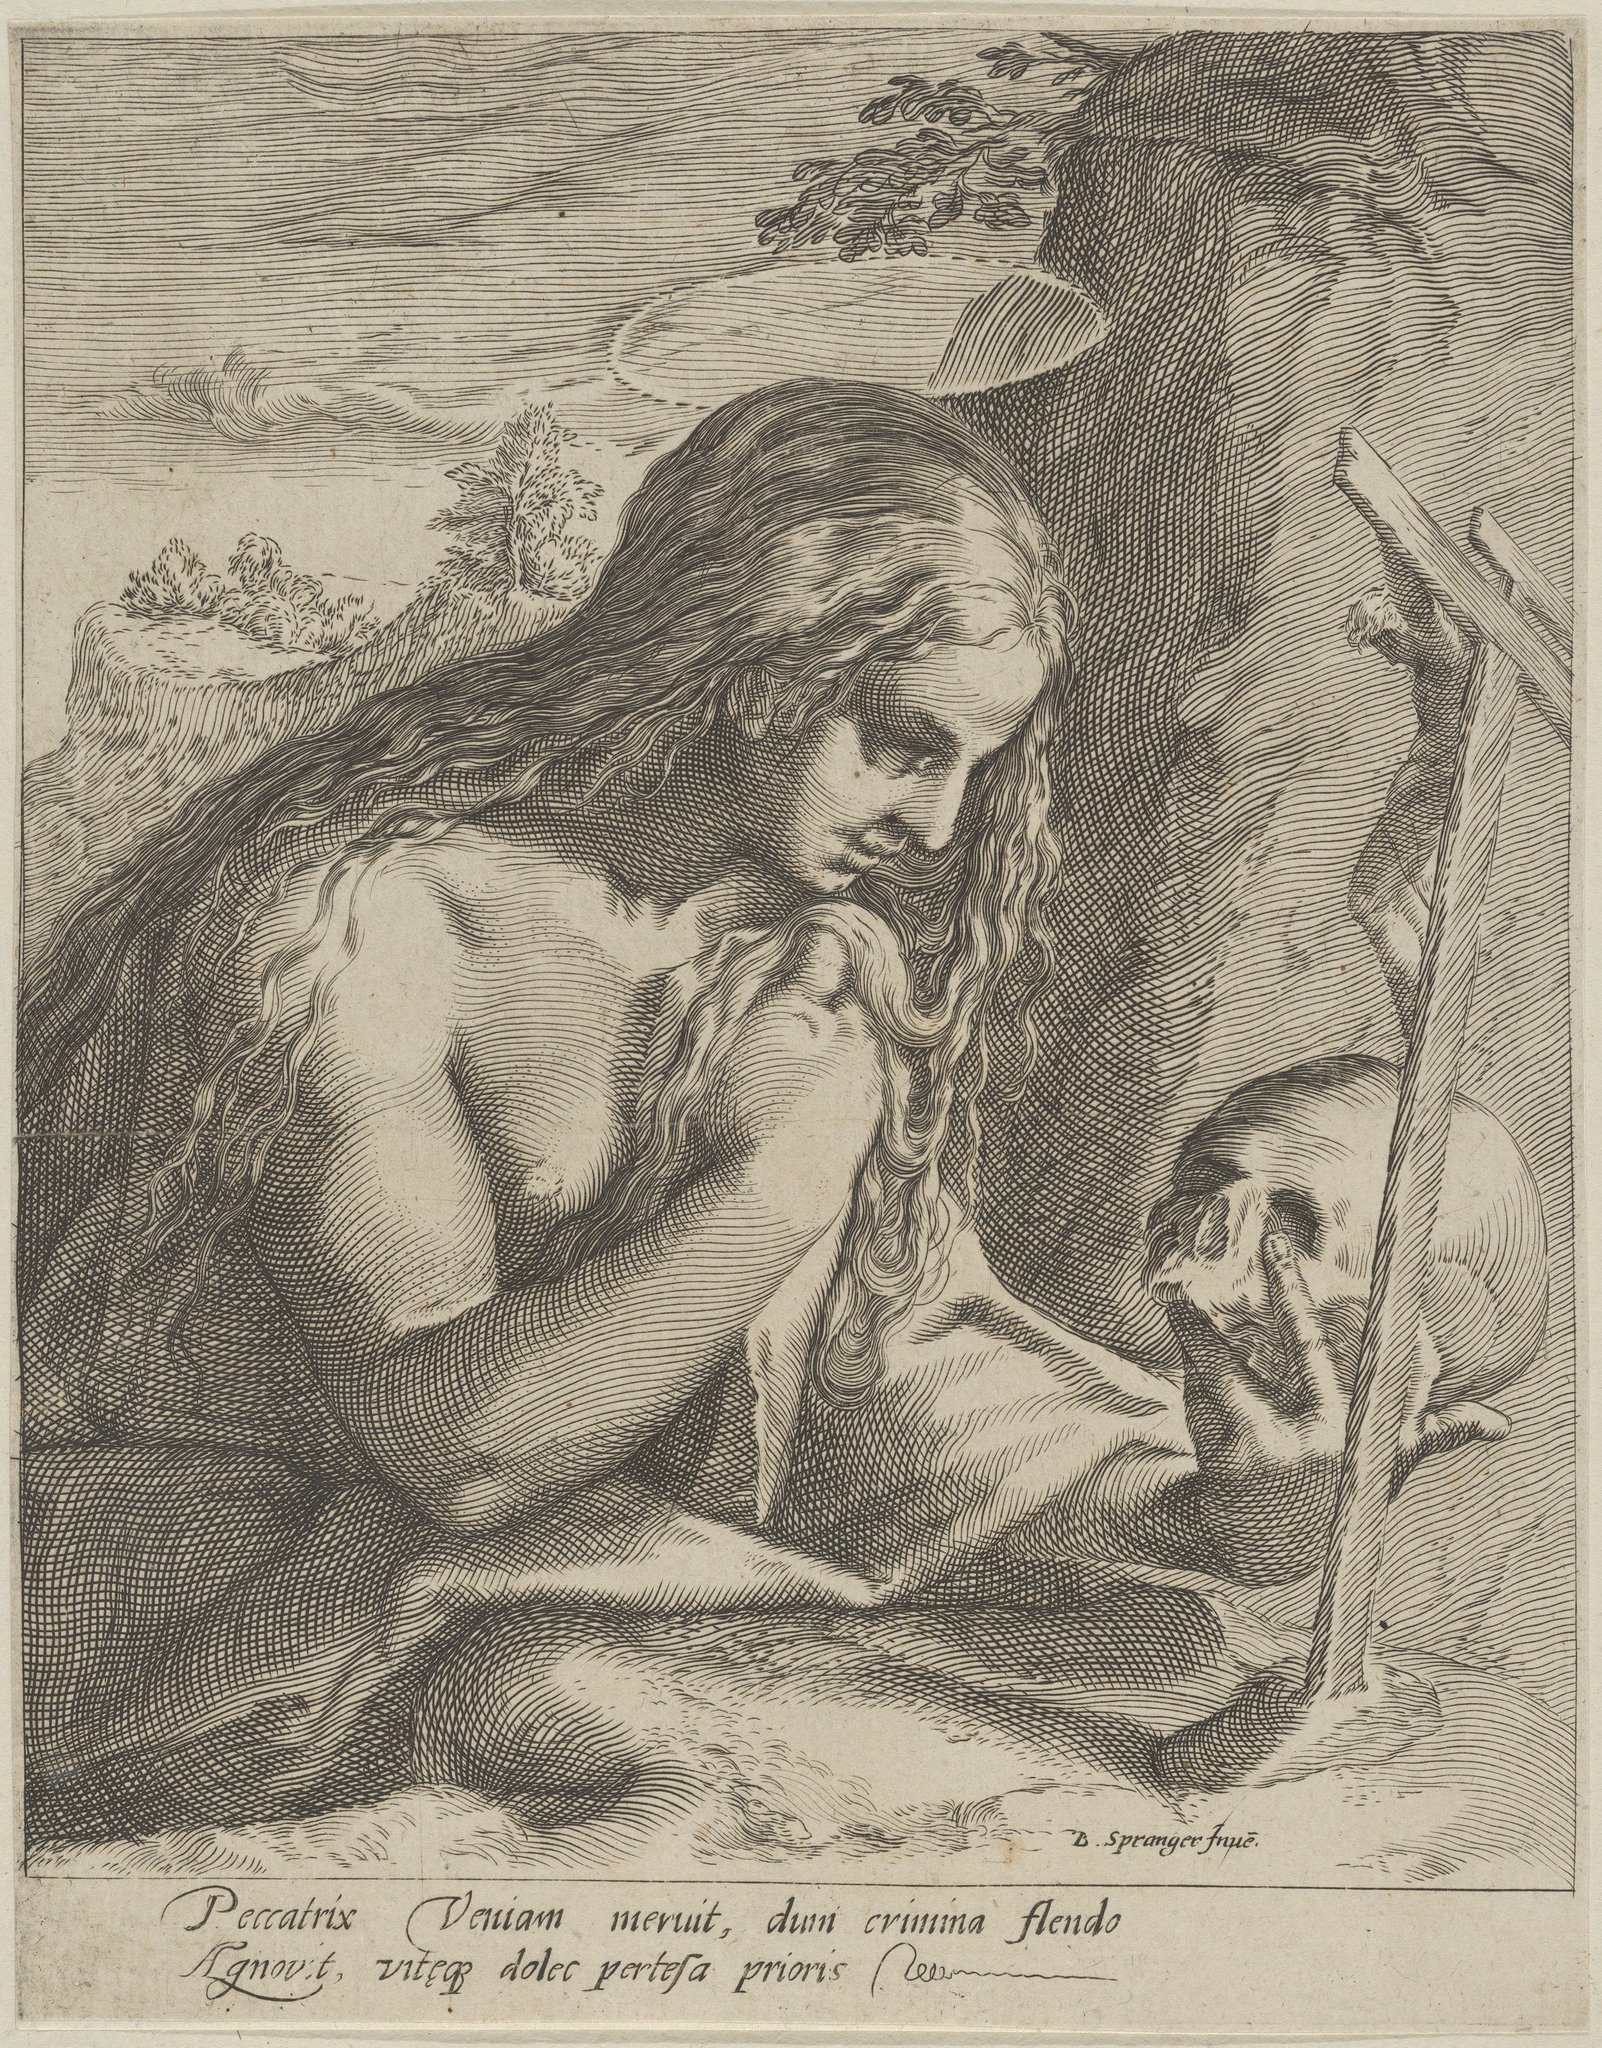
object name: print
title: Penitent Mary Magdalen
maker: bartholomeus spranger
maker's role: artist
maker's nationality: netherlandish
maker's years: 1546-1611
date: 1566-1631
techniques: engraving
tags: skulls,mary magdalene,cross